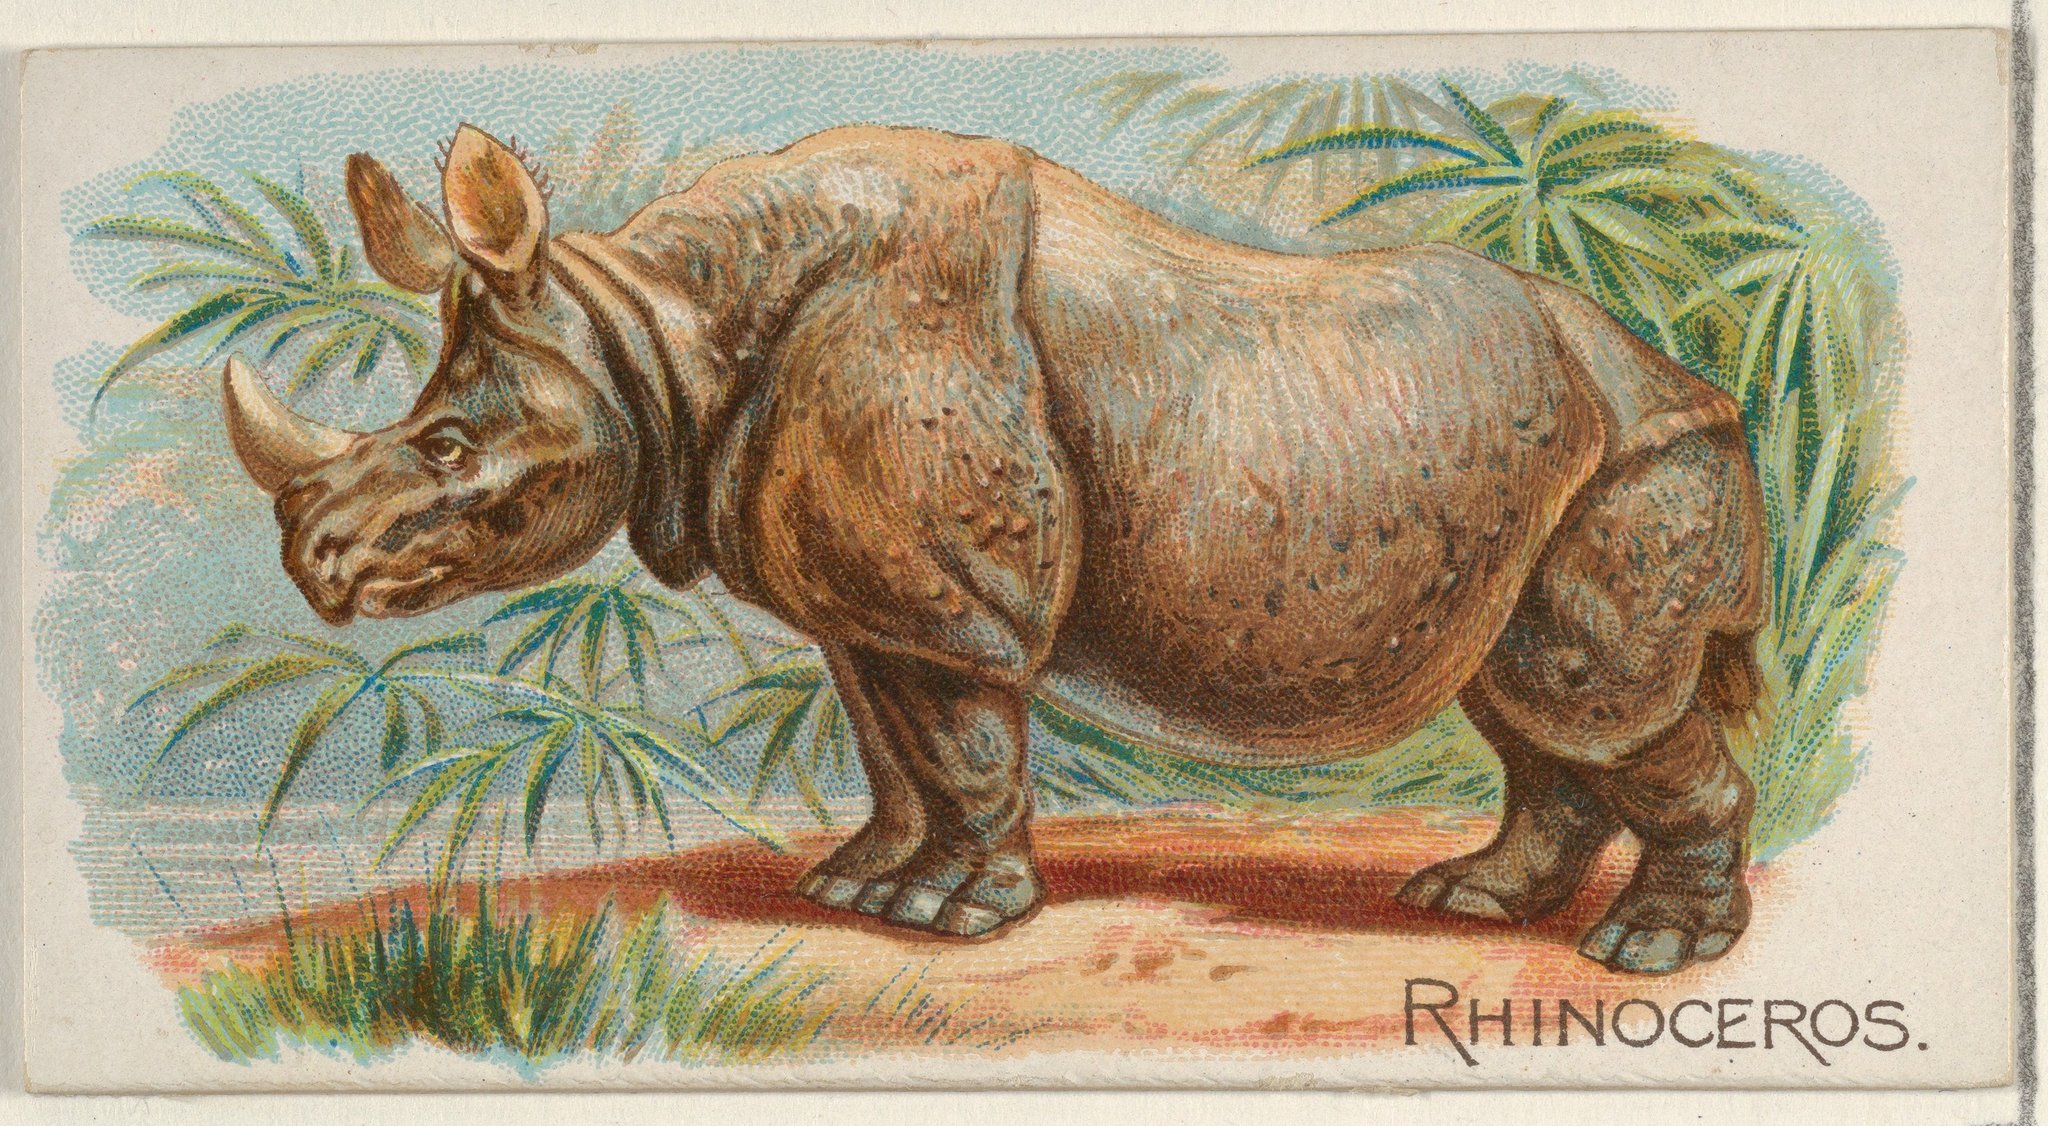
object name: print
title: Rhinoceros, from the Quadrupeds series (N21) for Allen & Ginter Cigarettes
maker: allen & ginter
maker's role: publisher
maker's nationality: american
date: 1890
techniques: color lithograph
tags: animals